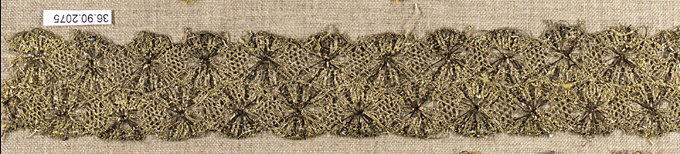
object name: piece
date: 1801-1900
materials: metal thread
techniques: lace